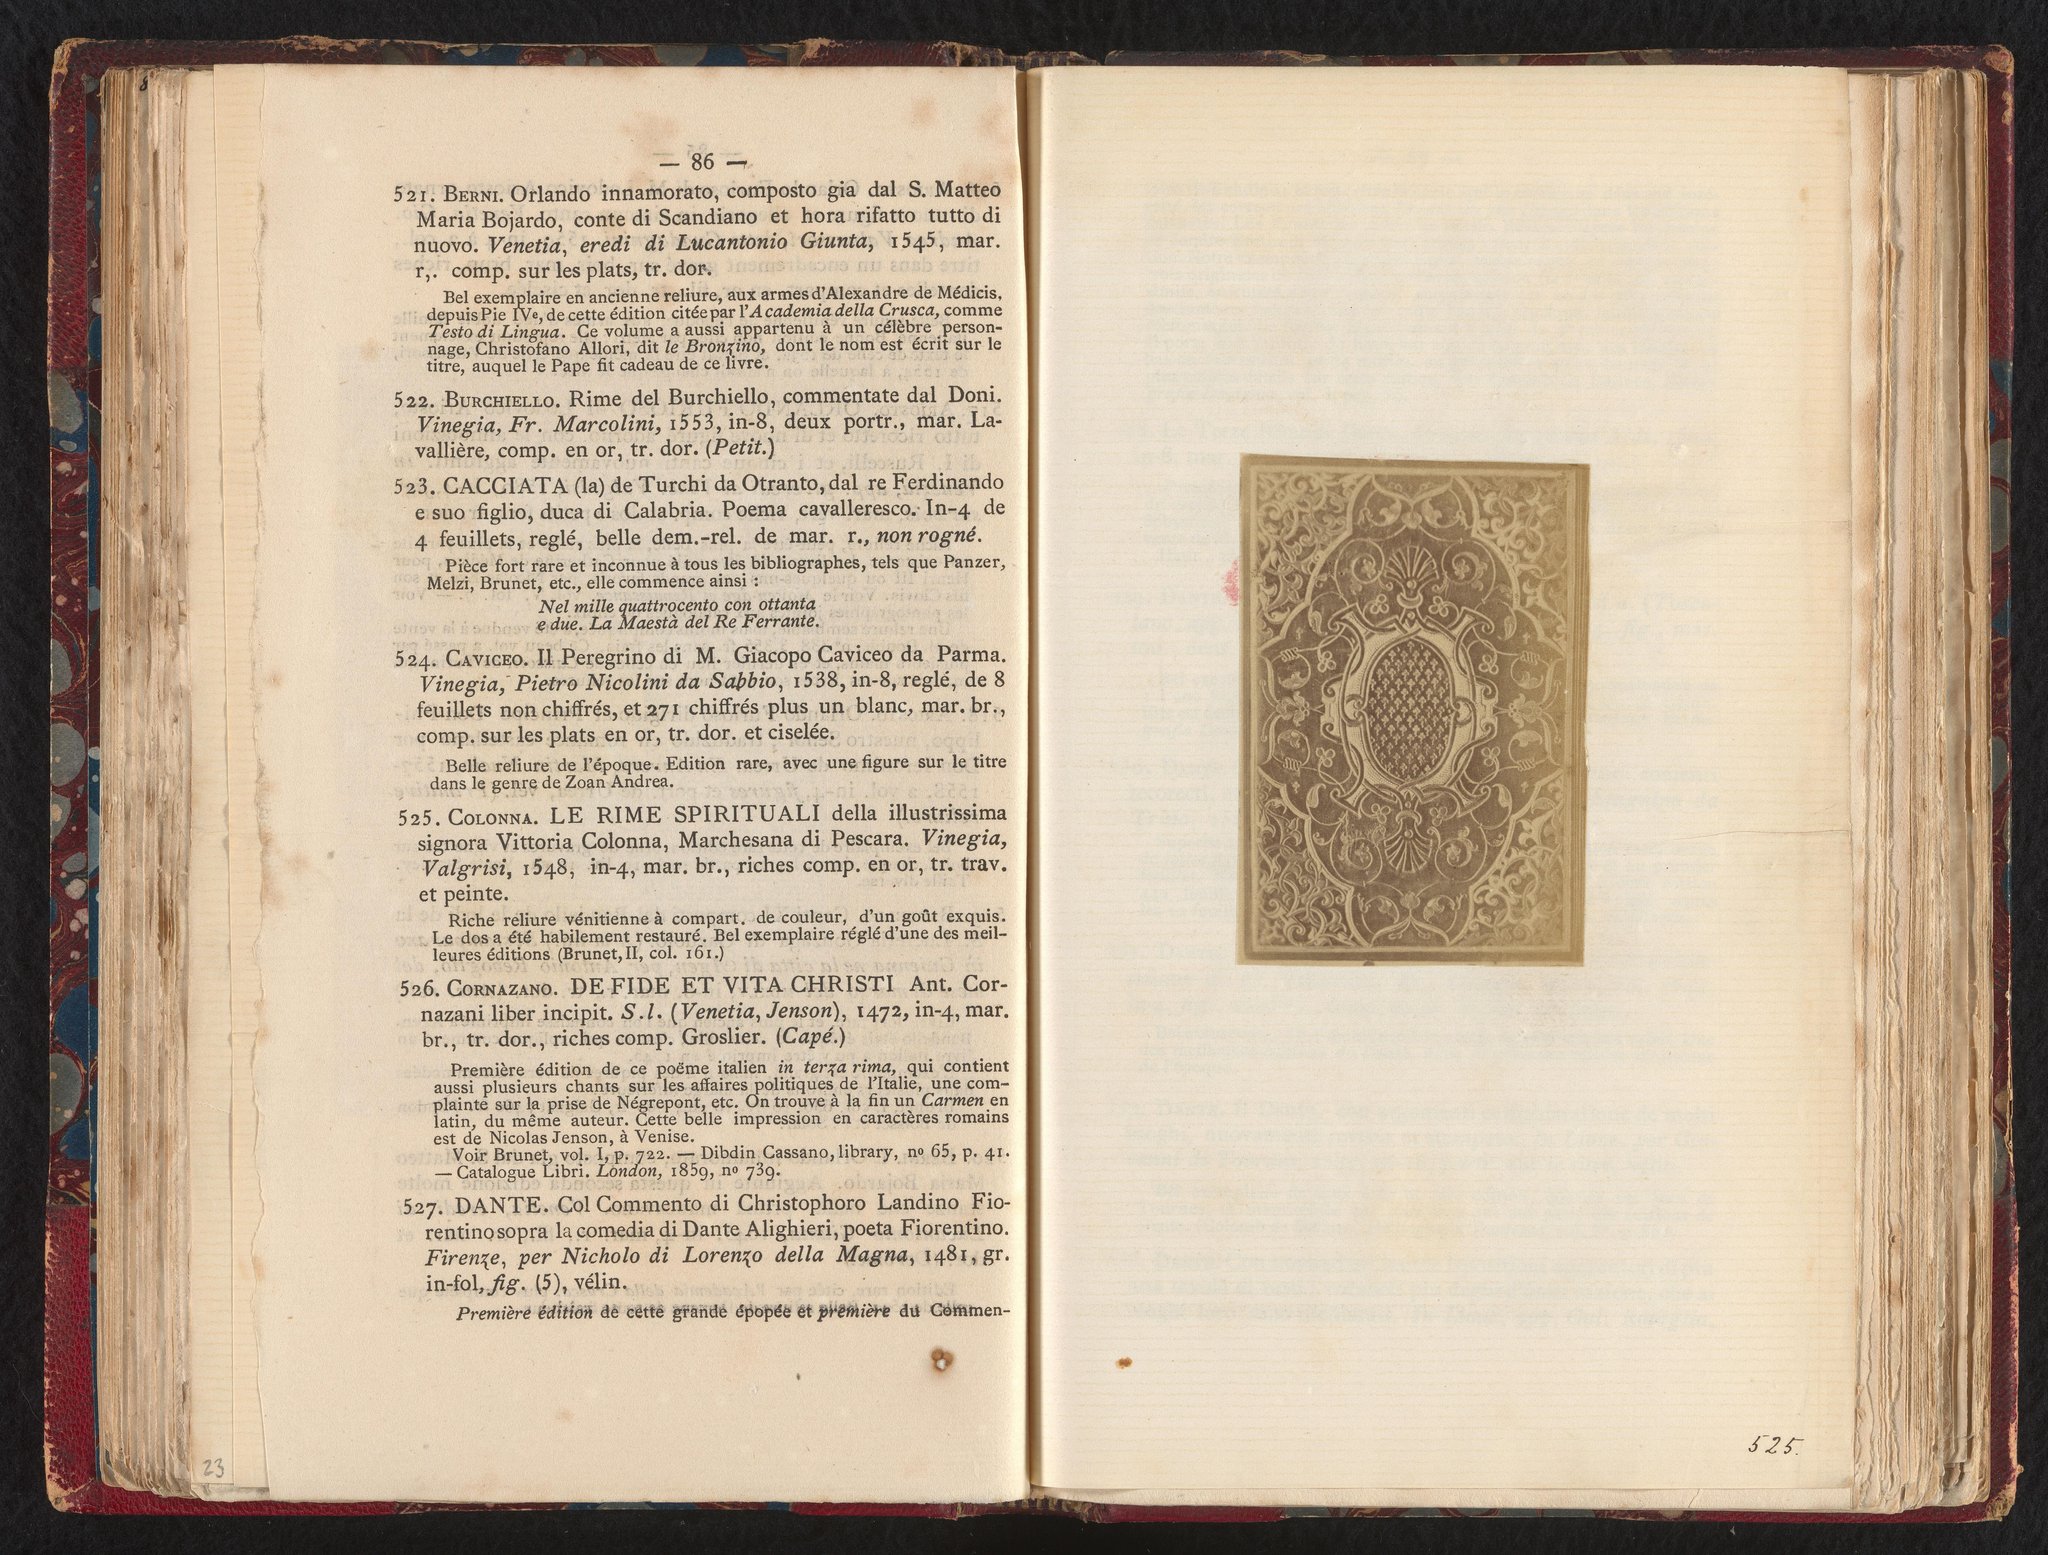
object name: page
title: Fotoreproductie van boekomslag van Le Rime Spirituali della illustrissima signora Vittoria Colonna uit 1548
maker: Anonymous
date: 1863-1868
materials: paper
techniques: albumen print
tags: book-cover, binding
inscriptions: number: ‘525’